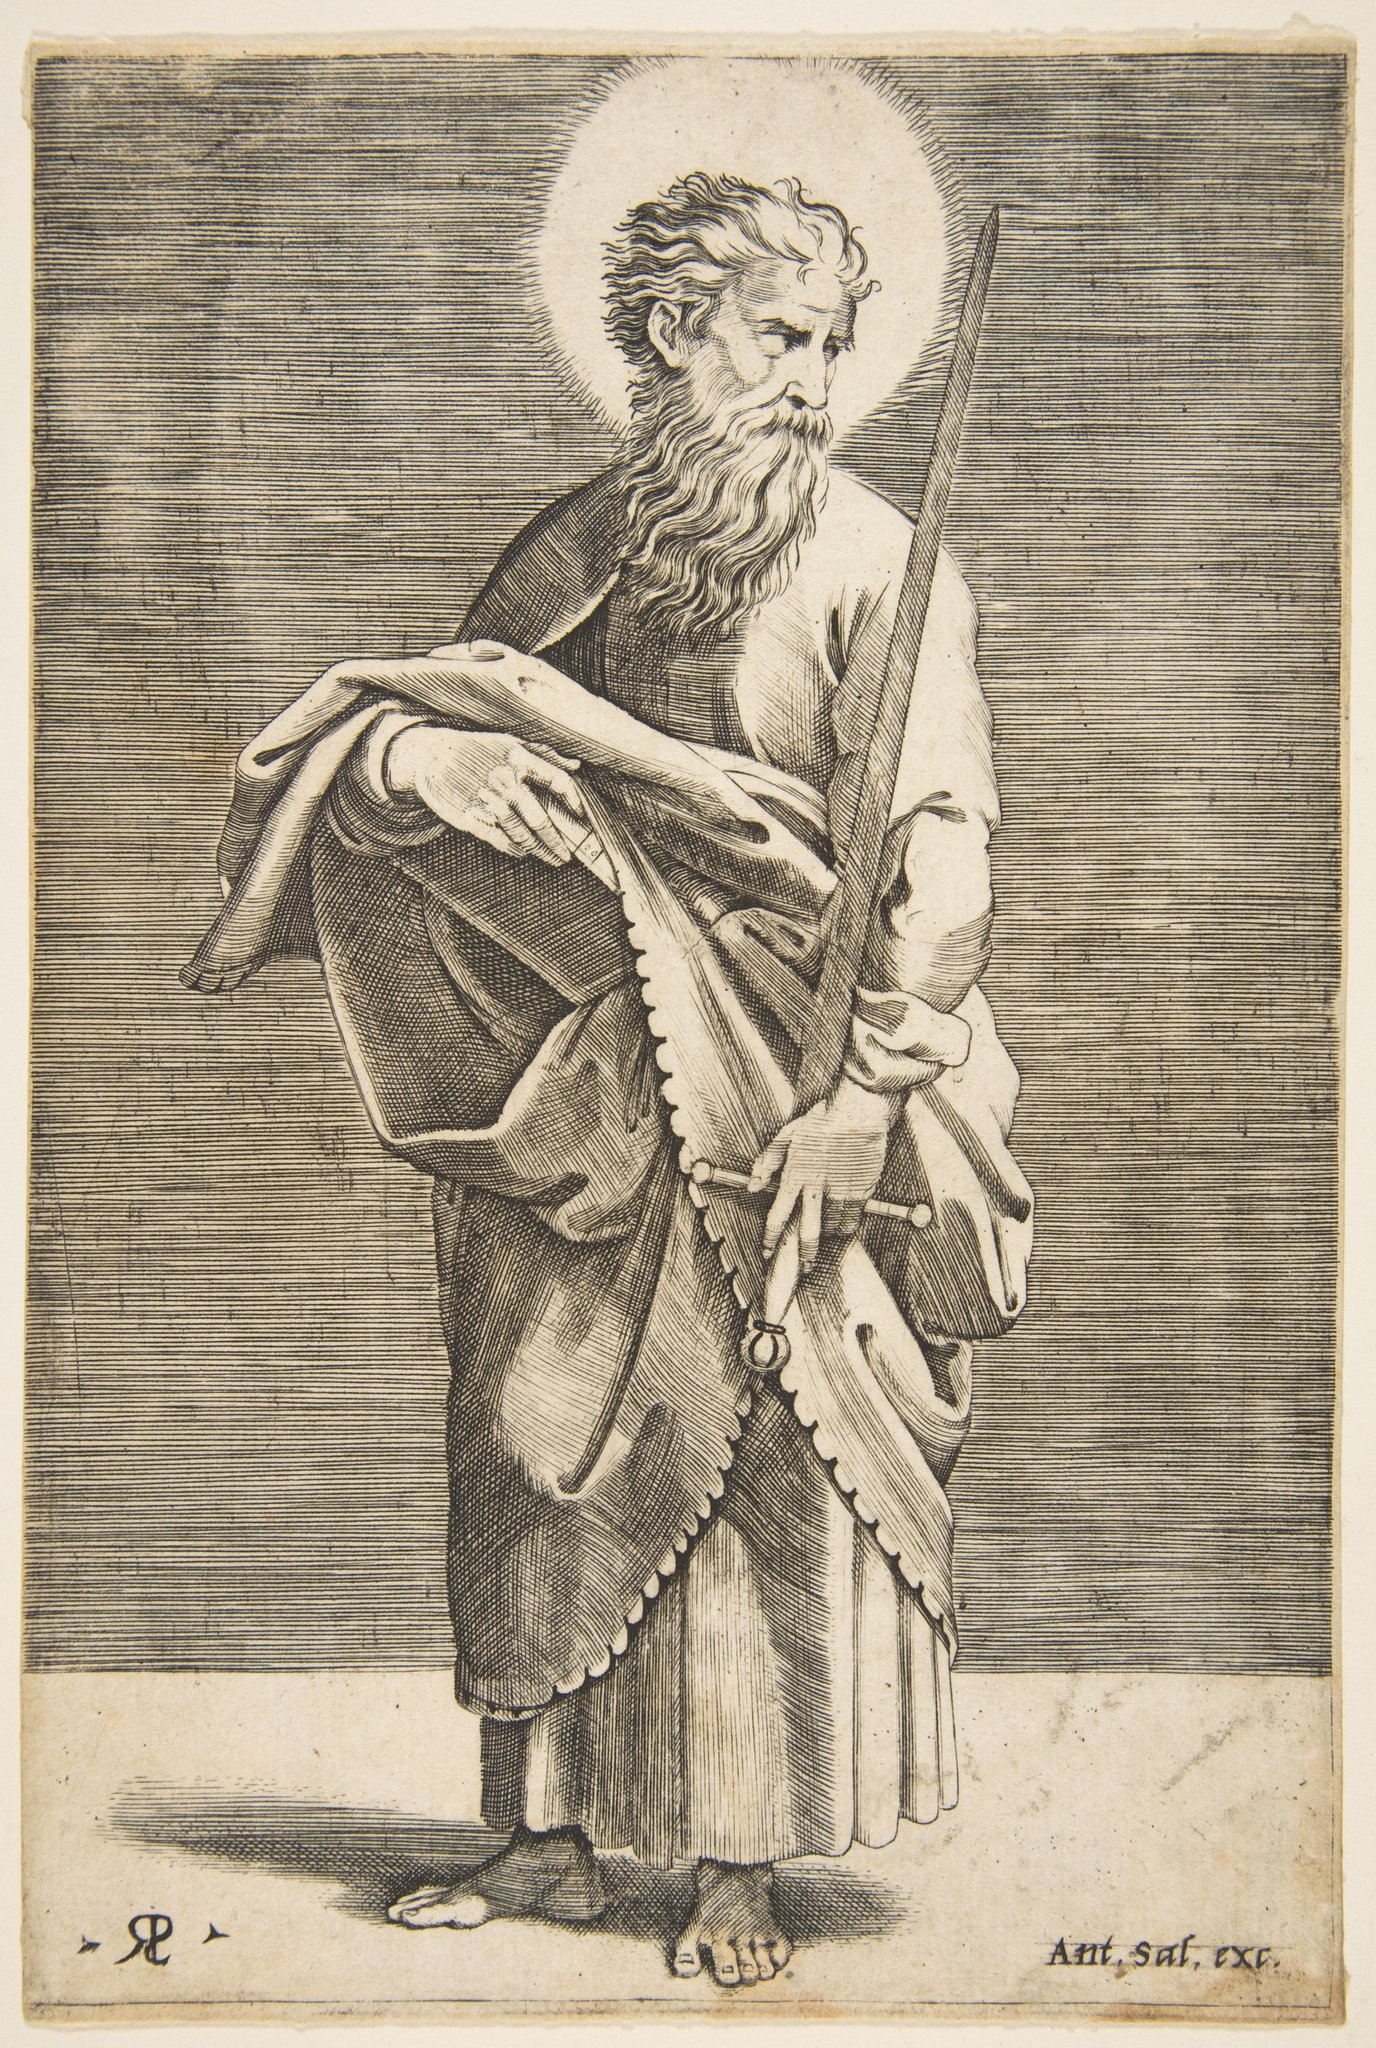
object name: print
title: Saint Paul looking to the right and holding a sword and a book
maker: marco dente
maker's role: artist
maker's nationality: italian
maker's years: 1515-1527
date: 1515-1527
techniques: engraving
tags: books,swords,saint paul